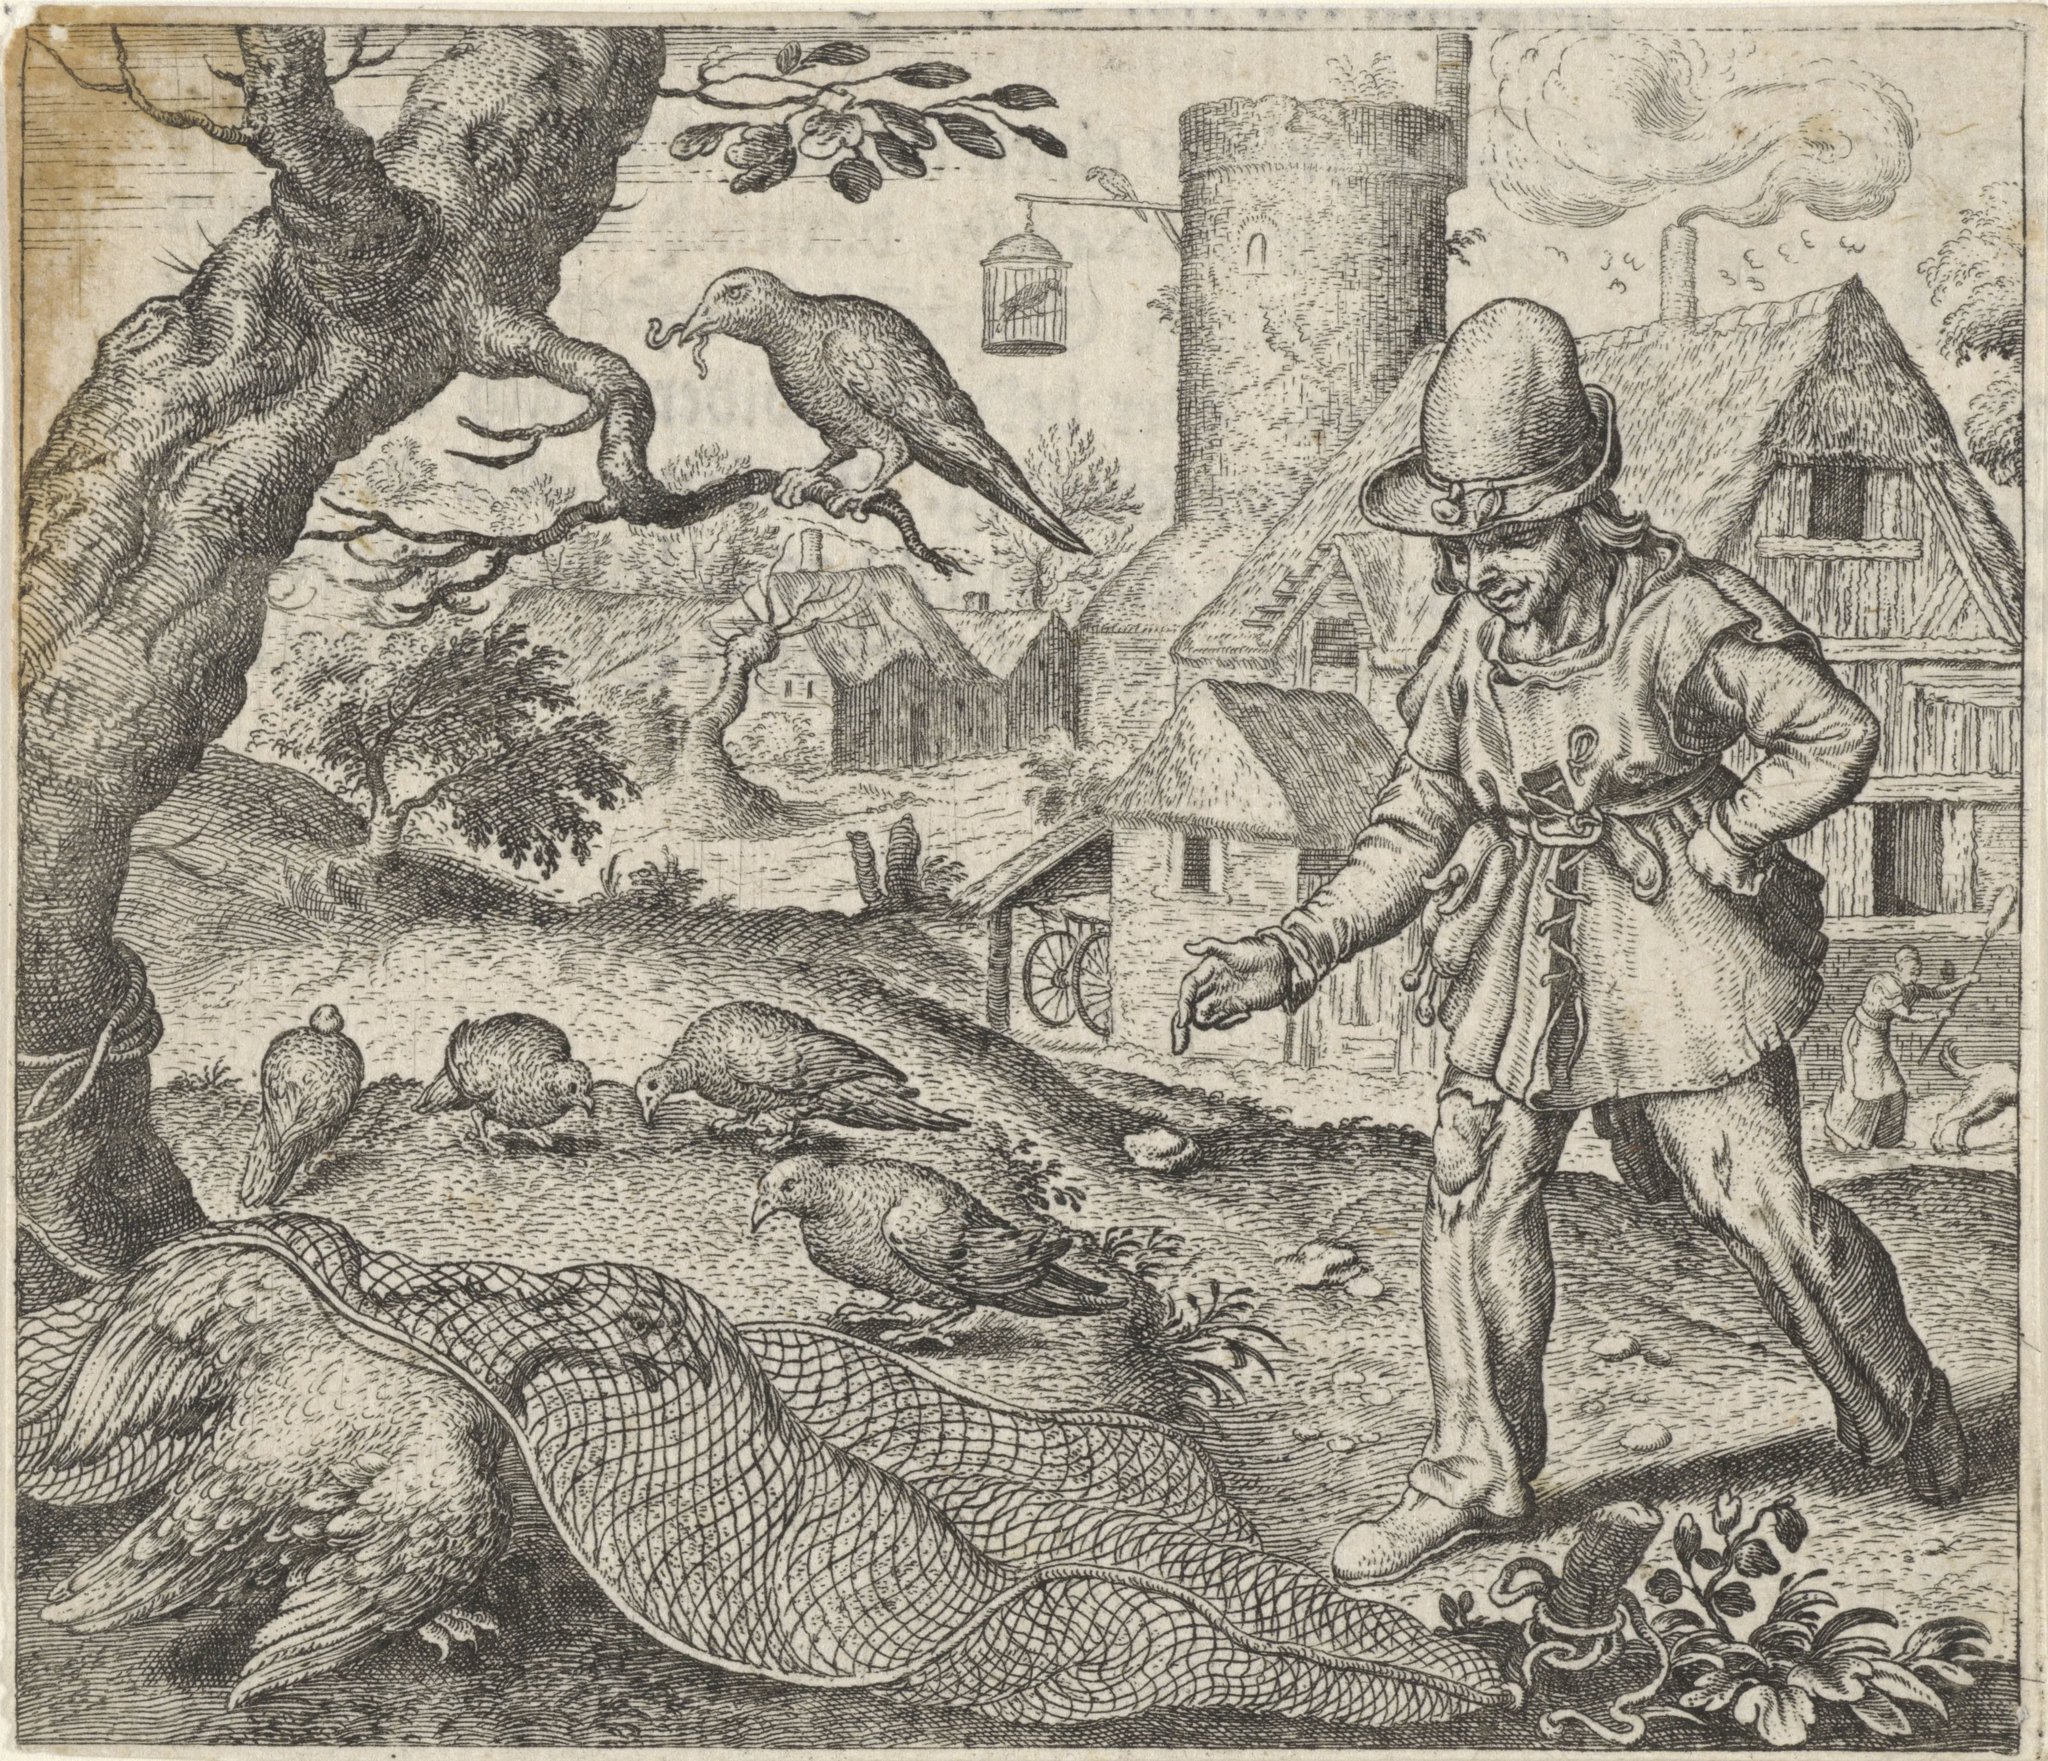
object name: print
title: Fabel van de kiekendief en de koekoek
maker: aegidius sadeler (ii)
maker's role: draughtsman, print maker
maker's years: 1568-1629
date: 1608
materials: paper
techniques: engraving, etching, letterpress printing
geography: prague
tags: other birds: cuckoo, predatory birds: harrier, fables, fowling, fowler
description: Een vogelvanger heeft een kiekendief in zijn net gevangen. In een boom zit een koekoek met een worm in de bek. De fabel beschrijft hoe een kiekendief een koekoek uitlacht omdat hij wormen eet. De kiekendief wordt vervolgens met een net gevangen door een boer en zal moeten boeten voor het roven van zijn kippen. De moraal van het verhaal leert dat een sobere levensstijl beter is dan overdaad.